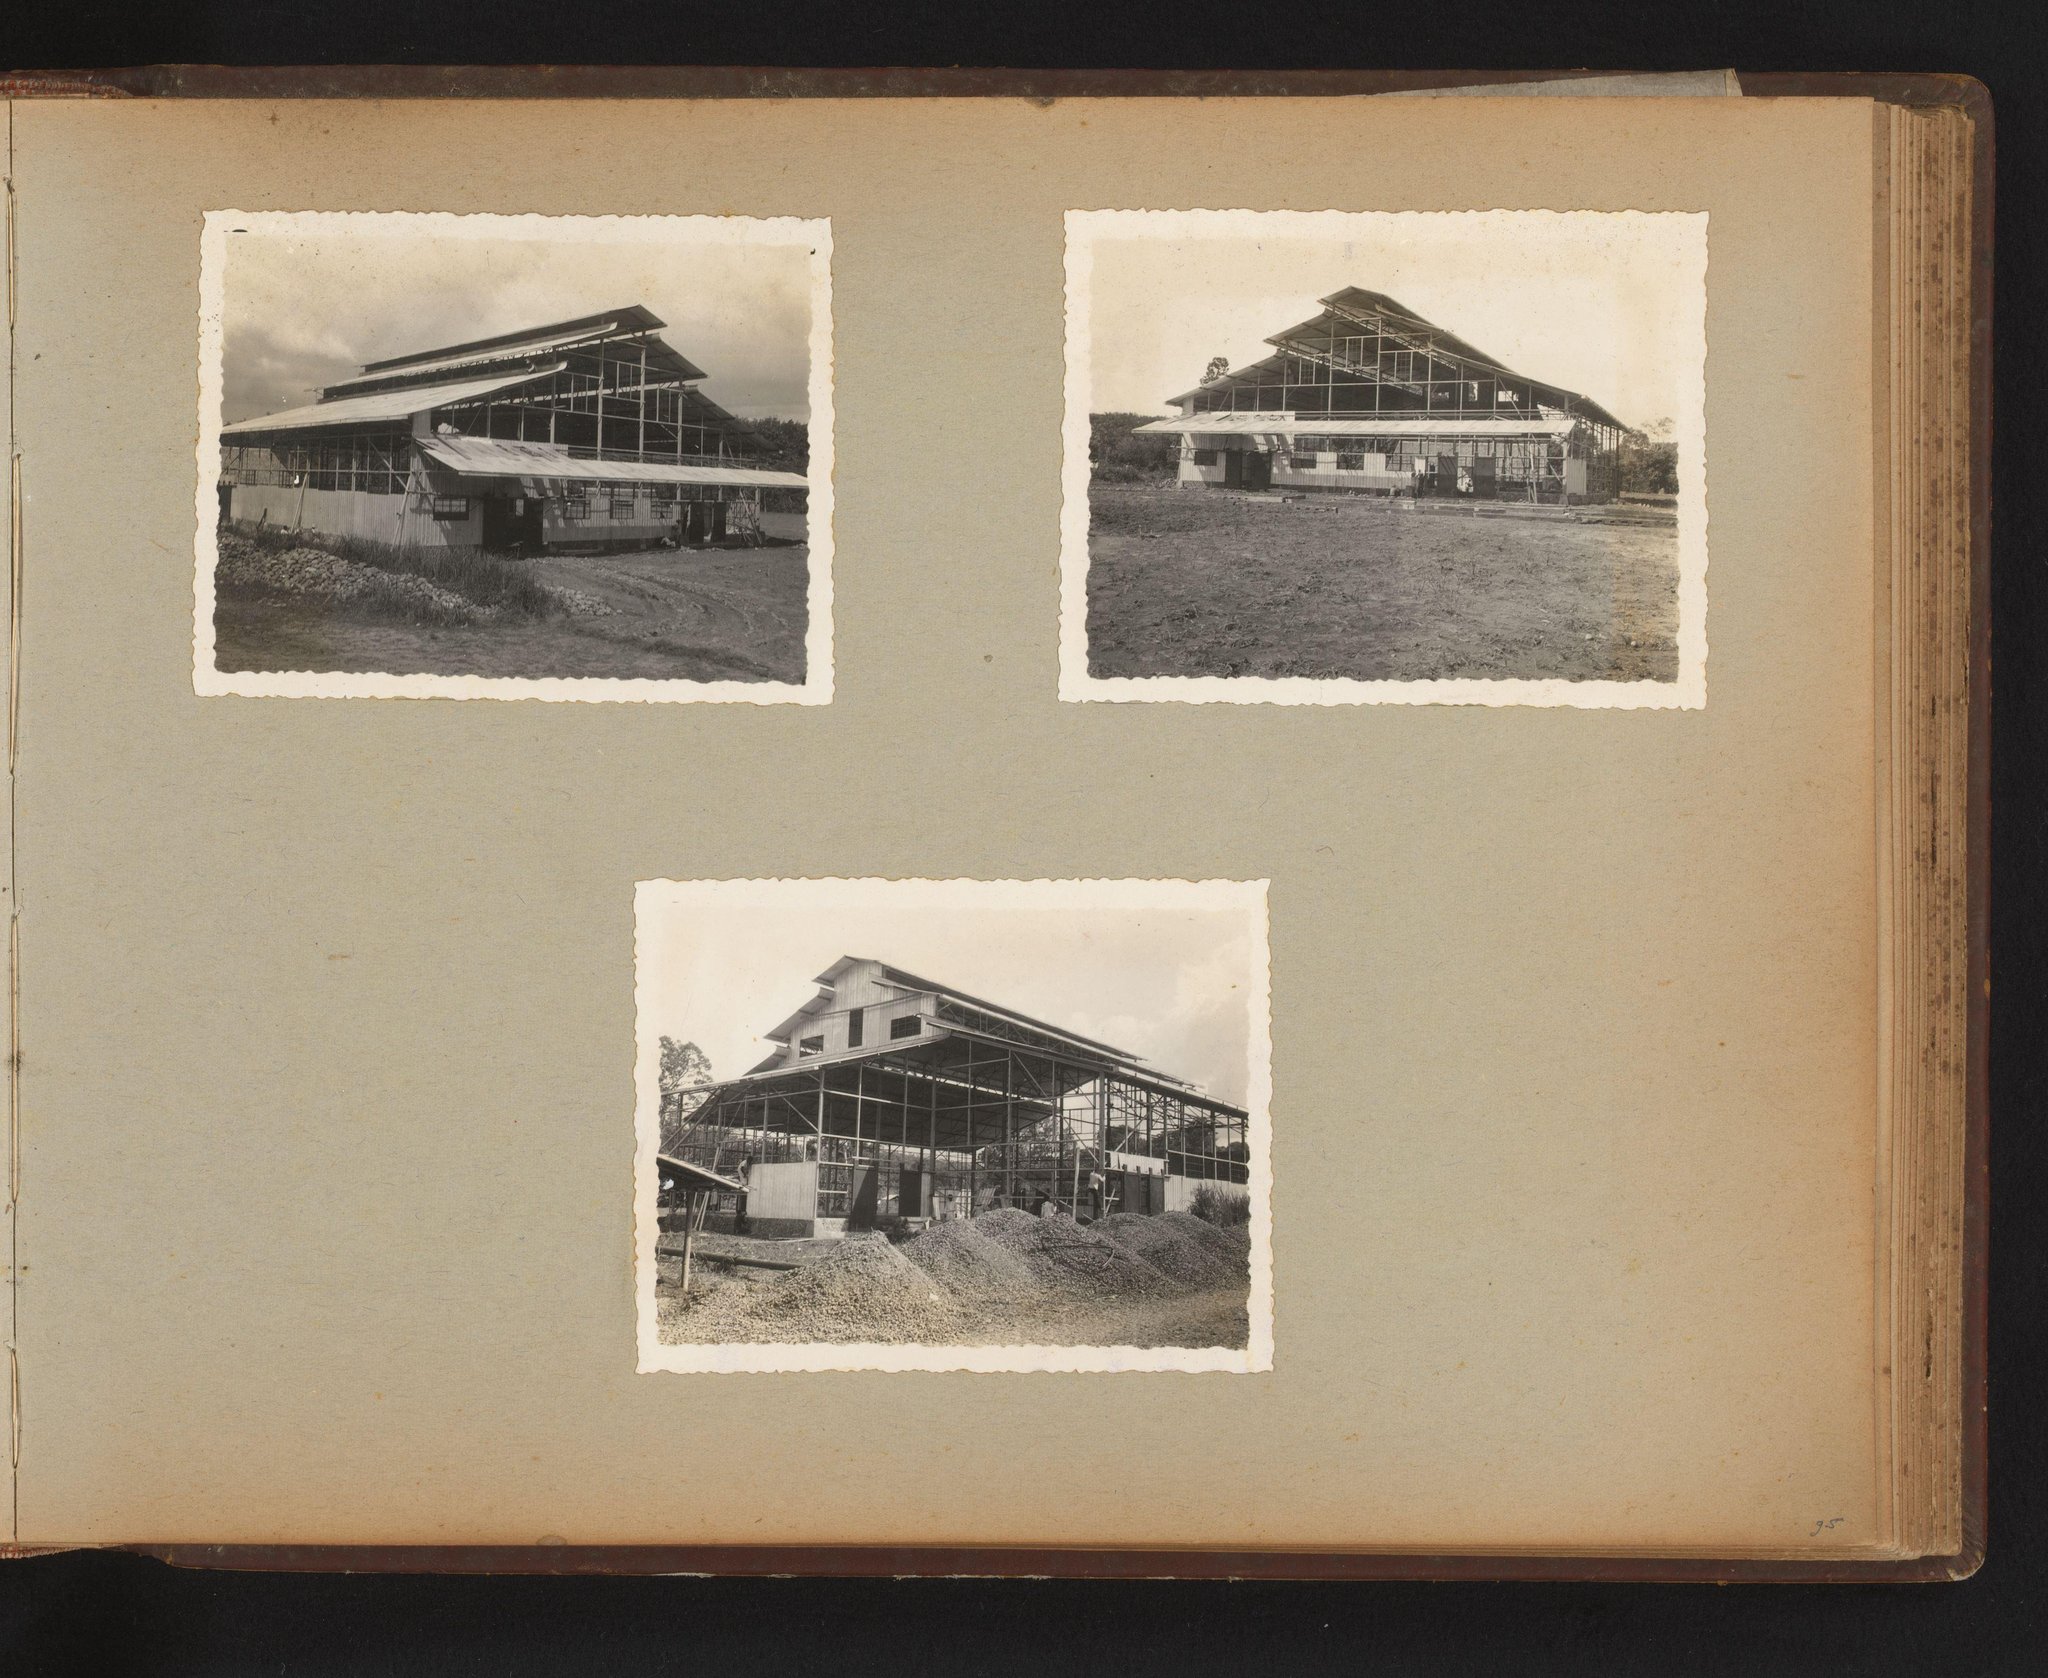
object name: photograph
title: Bouw van een bedrijfshal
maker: Anonymous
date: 1931-1937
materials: cardboard, photographic support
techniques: gelatin silver print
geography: java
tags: making the carcass (~ building activities), java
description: Albumblad met drie foto's van de bouw van een bedrijfshal. Onderdeel van een fotoalbum met foto's van machines en constructies van de N.V. Machinefabriek Braat te Soerabaja, Soekaboemi en Tegal uit de periode 1931-1937.